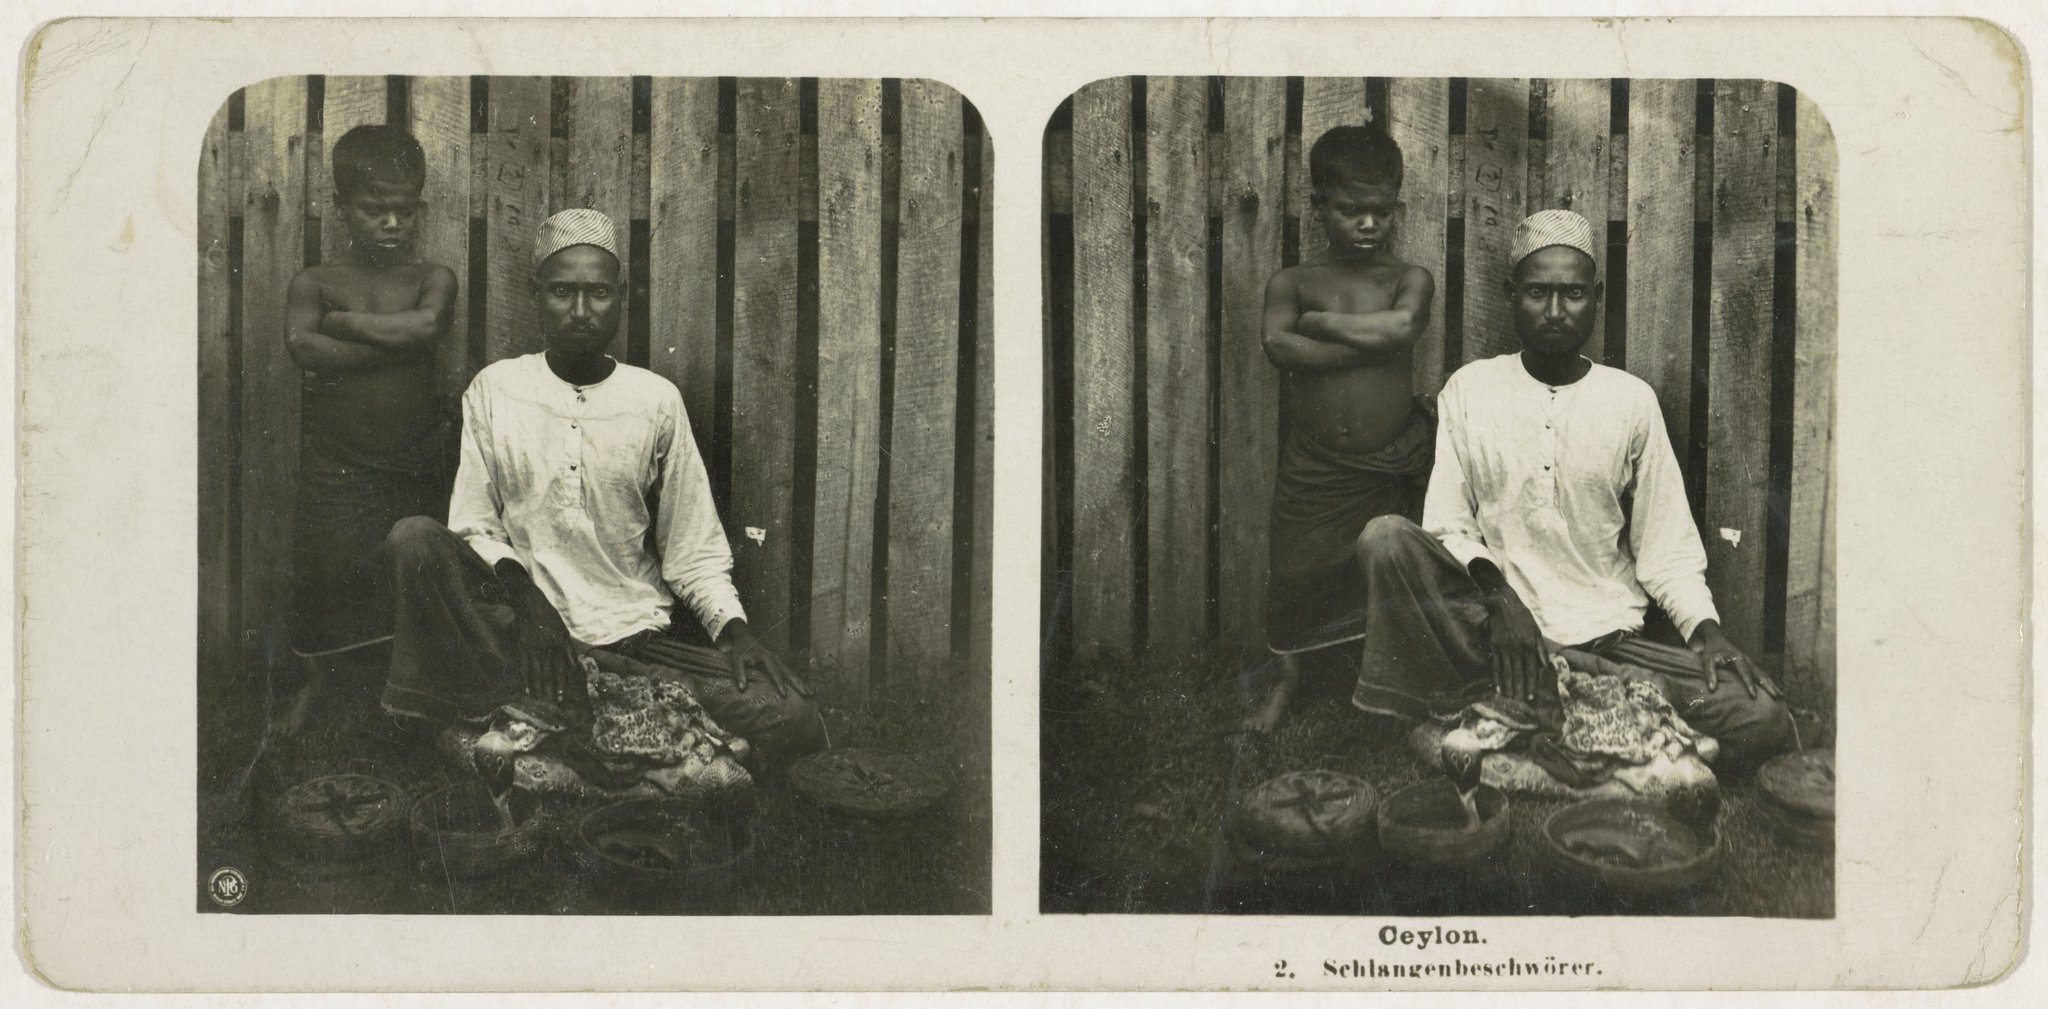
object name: stereograph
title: Schlangenbeschwörer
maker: Anonymous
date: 1909-1935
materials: paper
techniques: gelatin silver print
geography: steglitz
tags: snakes, sri lanka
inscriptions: number: ‘2.’, number: ‘408’, inscription: ‘M.J. Broekhuijsen’